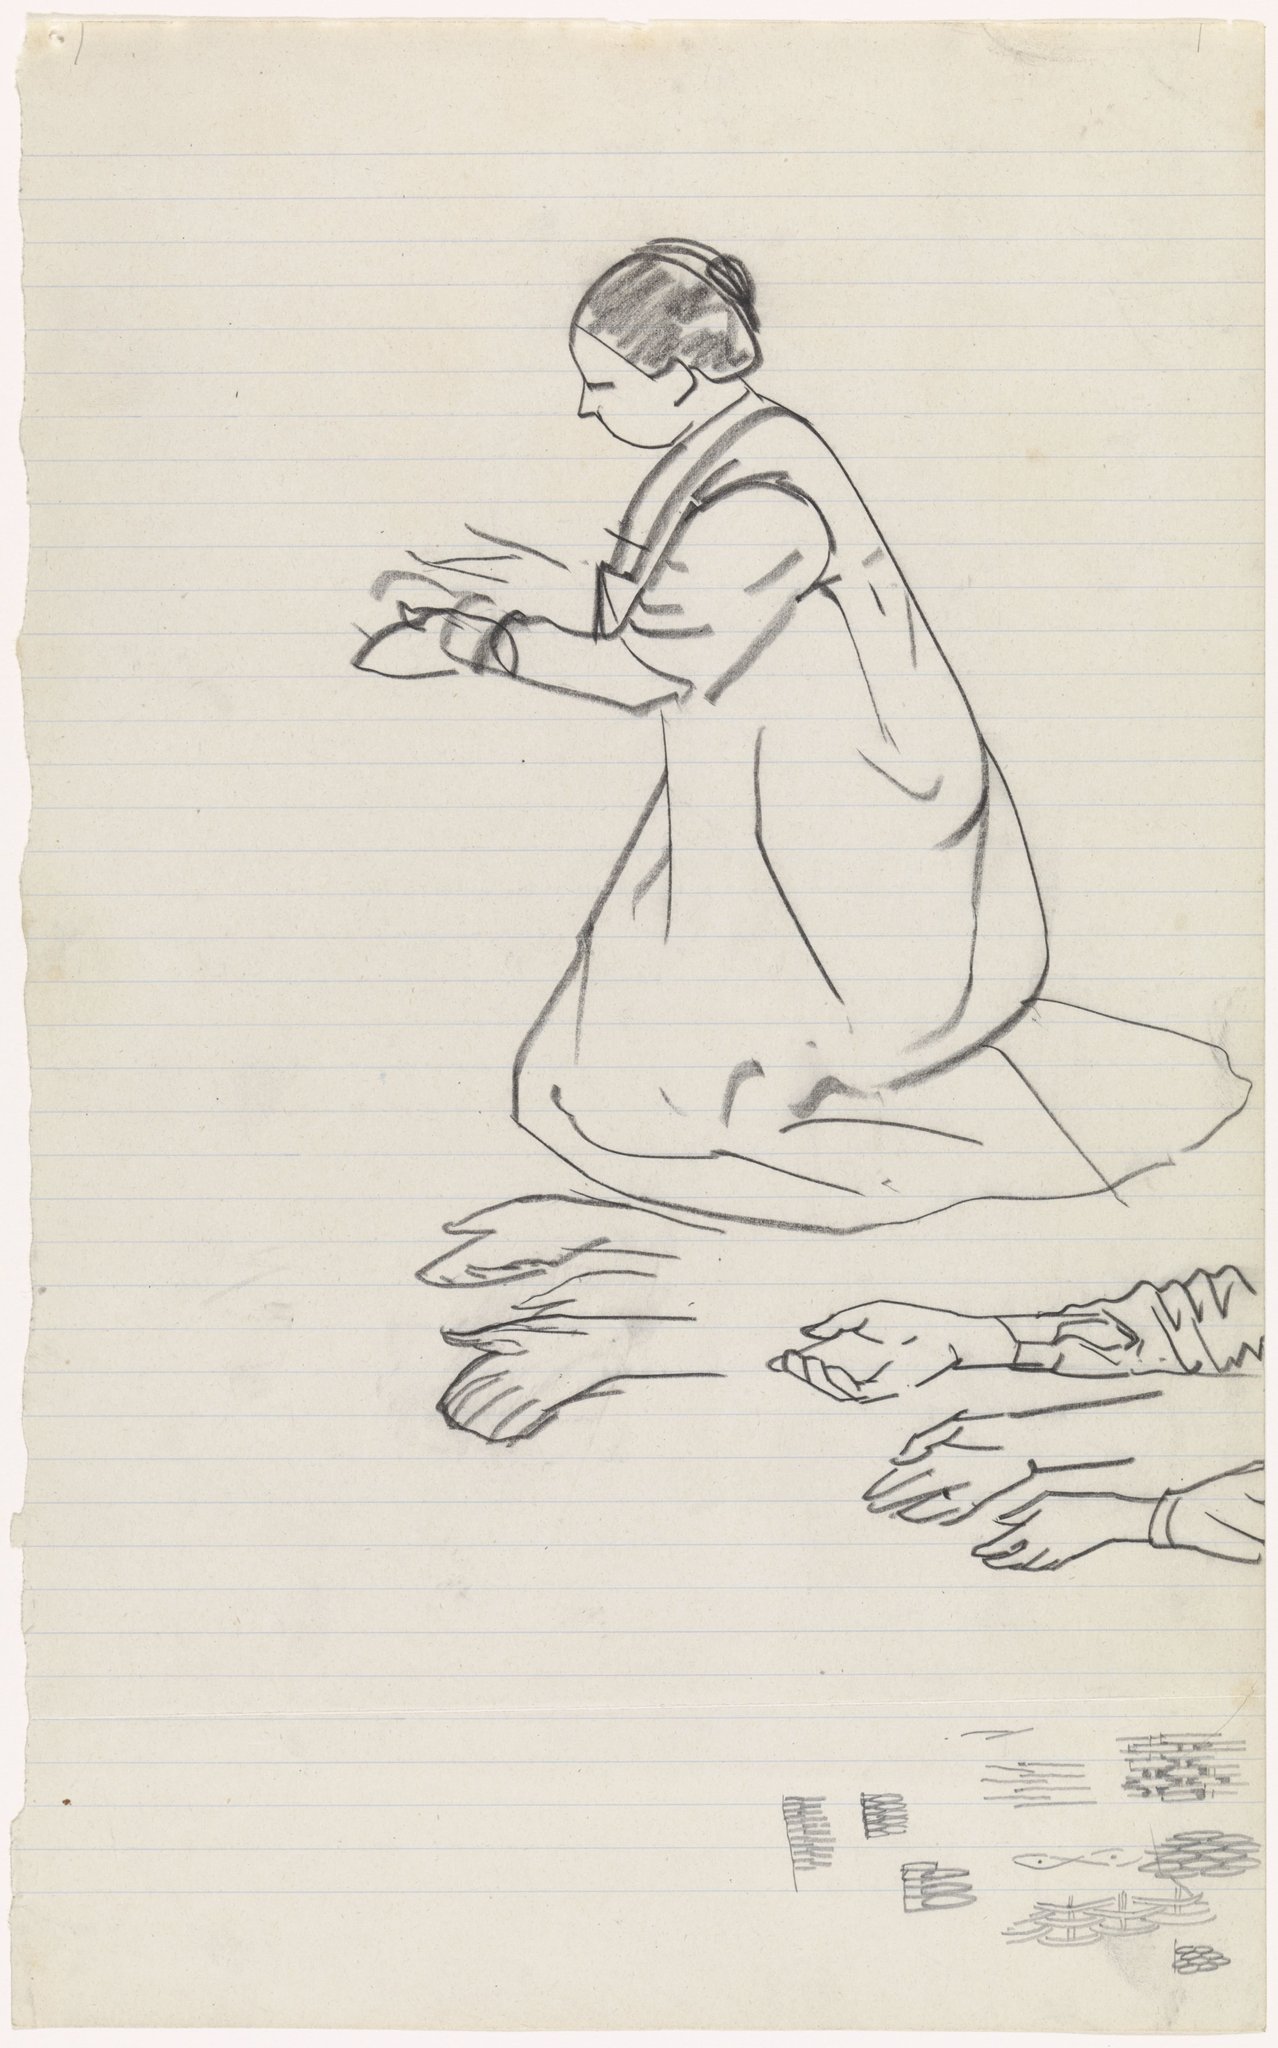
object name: drawing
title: Knielende vrouw en detailstudies van de handen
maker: gerrit willem dijsselhof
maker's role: designer, draughtsman, print maker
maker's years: 1866-1924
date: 1876-1901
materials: chalk, paper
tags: hand